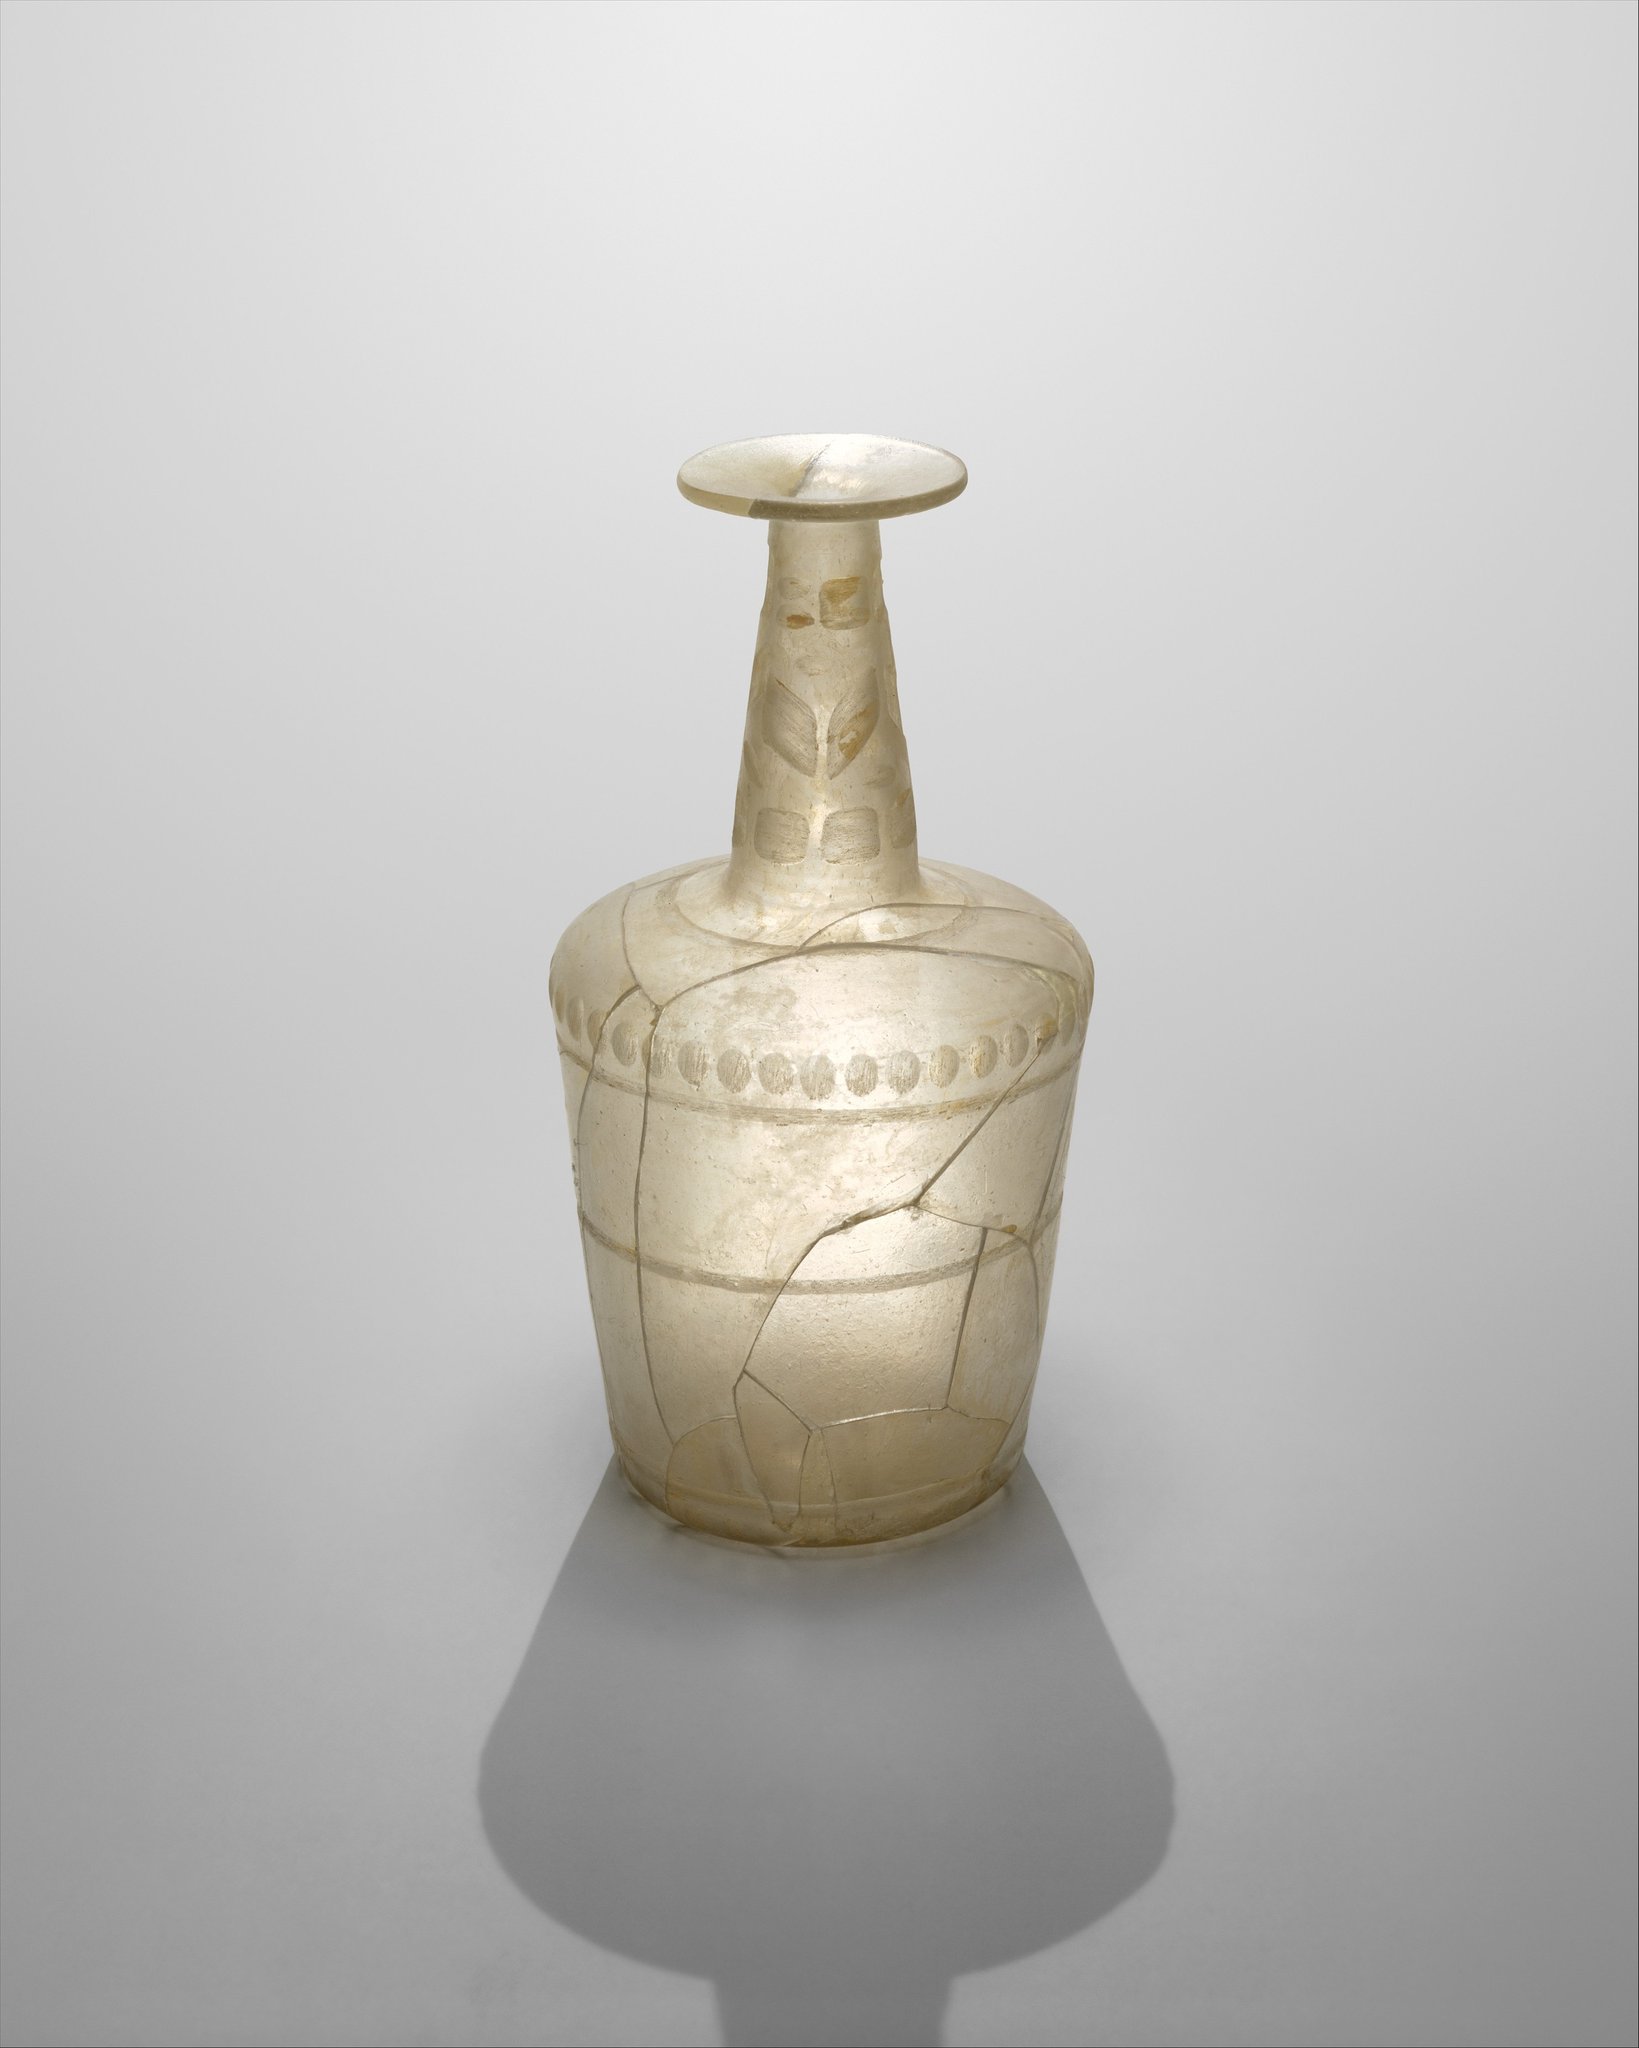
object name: bottle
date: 1001-1050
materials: glass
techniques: glassblowing, cutting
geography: iran